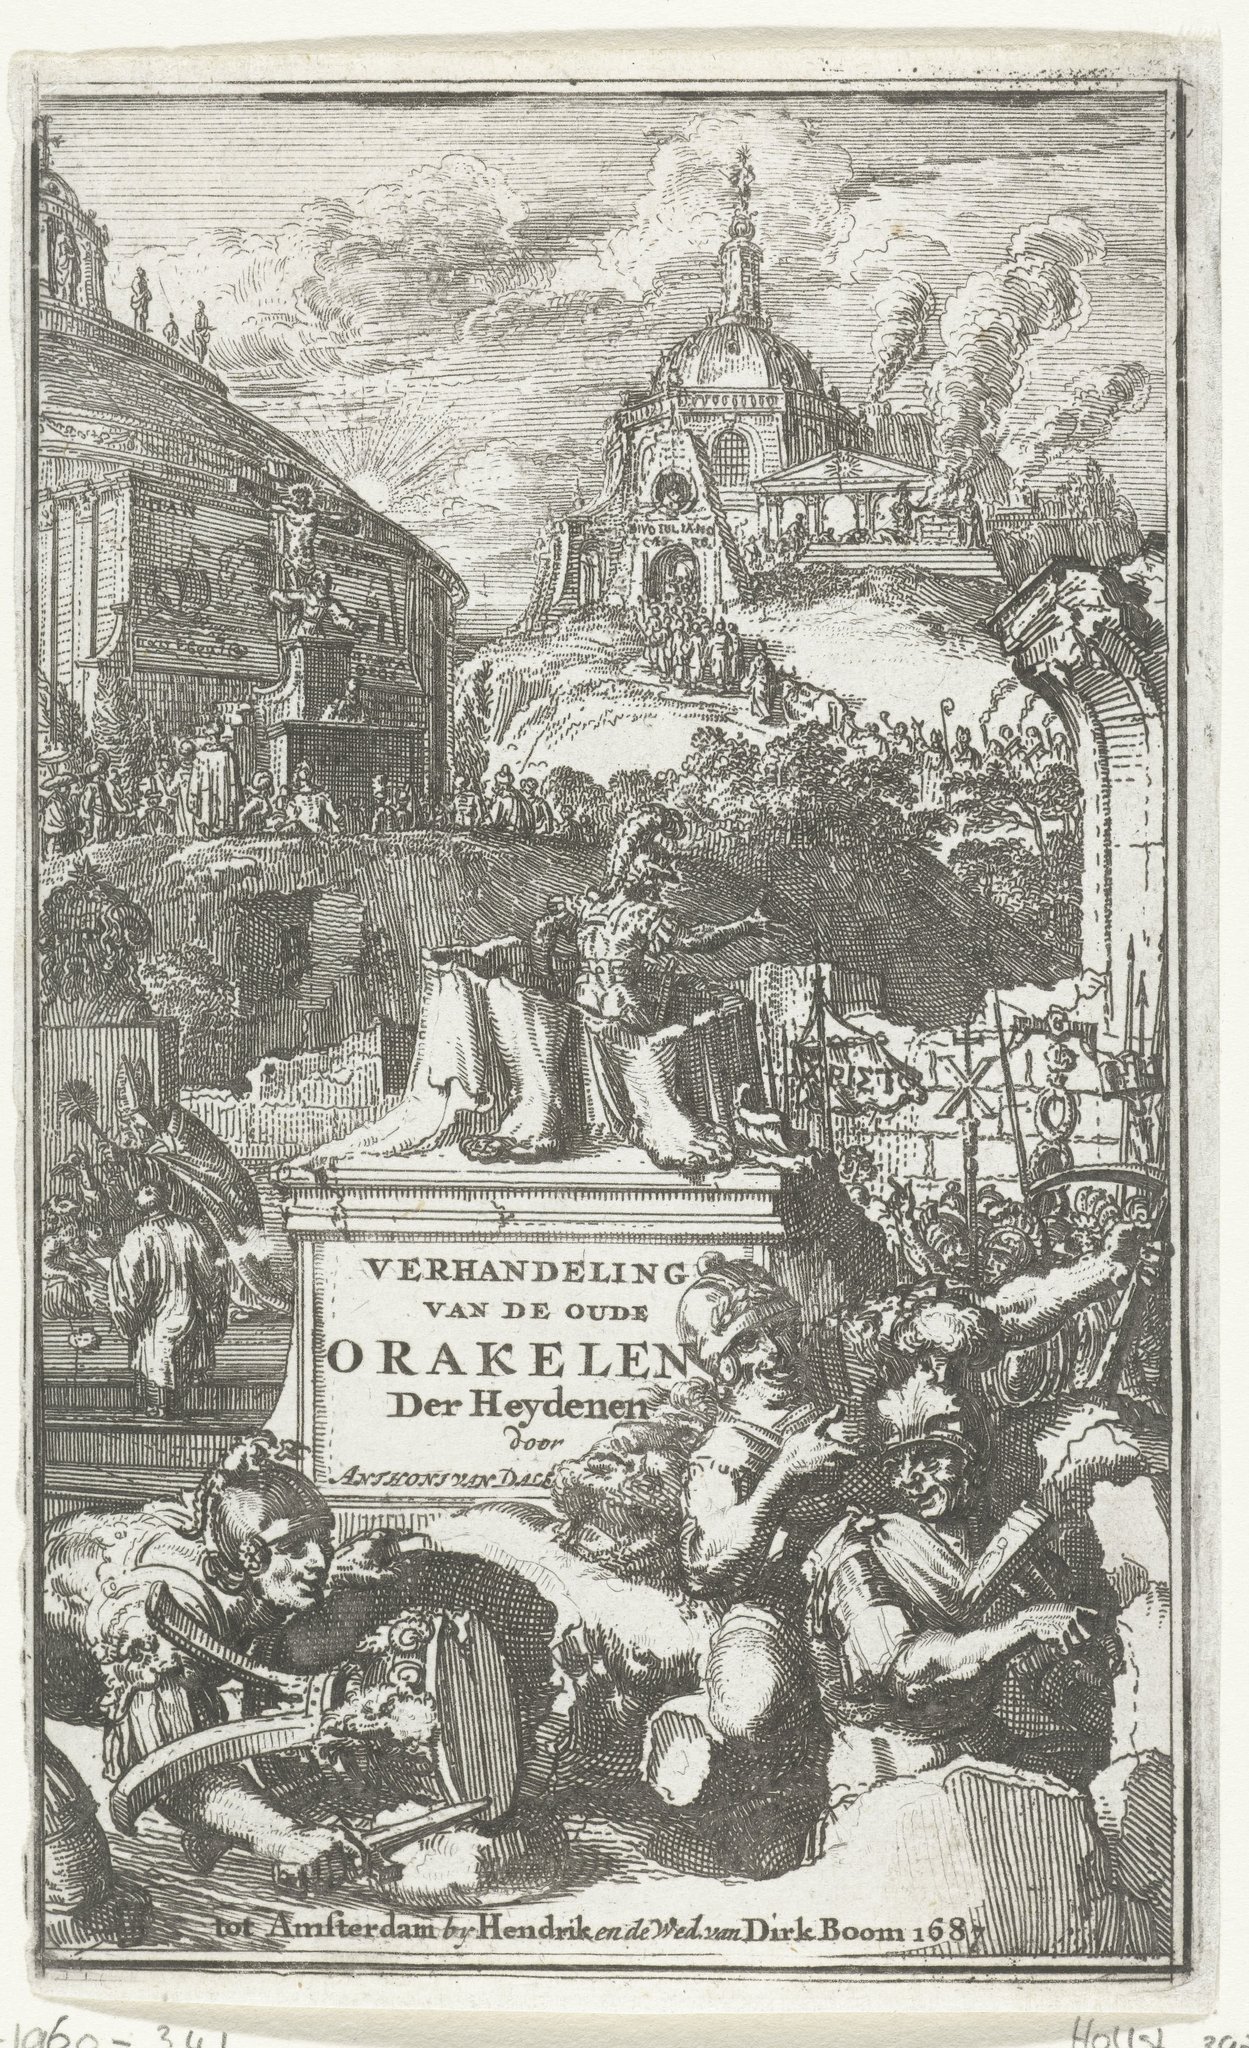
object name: book illustration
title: Titelprent voor 'Verhandeling van de oude orakelen der Heydenen' van Anthoni van Dale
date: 1687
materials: paper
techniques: etching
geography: amsterdam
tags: statues, paintings, etc. ~ objects of worship in roman religion, temple, shrine ~ roman religion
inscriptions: collector's mark: Lugt 2228a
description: Sokkel met tekst met daarop afgebroken beeld waarvan alleen de voeten nog staan. In het holle beeld staat een soldaat. Voor de sokkel ligt de rest van het beeld met eromheen lachende soldaten. Op de achtergrond heuvels met tempels.